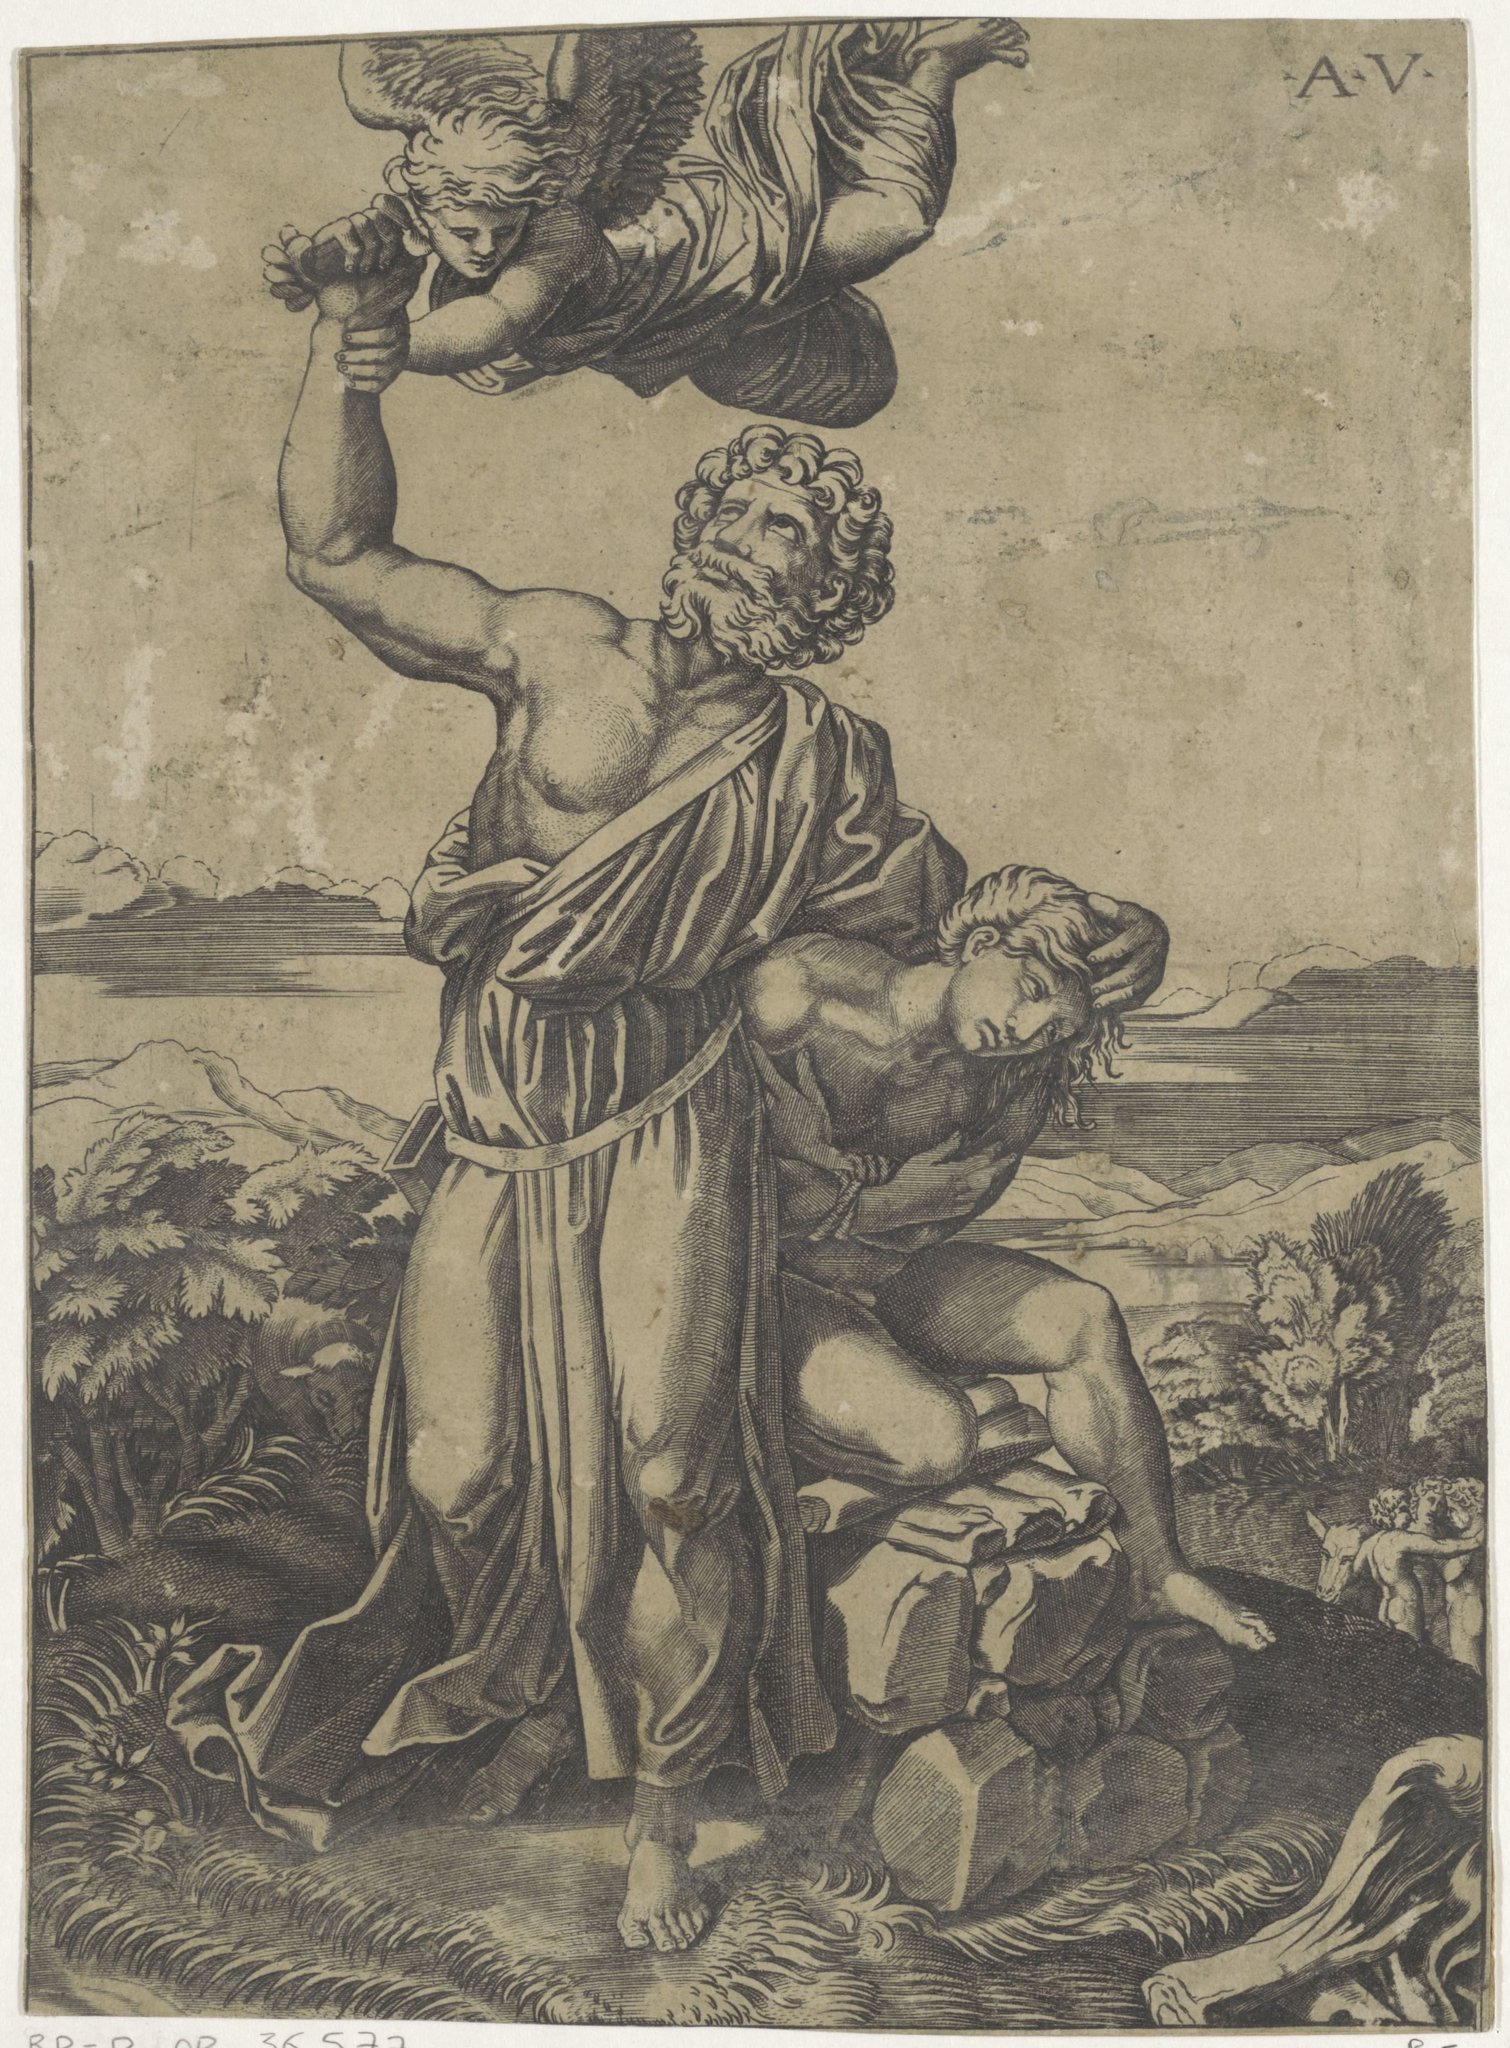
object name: print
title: Offer van Isaak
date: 1500-1536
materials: paper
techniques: engraving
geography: italy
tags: the sacrifice of isaac (genesis 22)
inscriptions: inscription: ‘L = C’, collector's mark: Lugt 240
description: Abraham staat op het punt om met zijn zwaard Isaak, die naast hem zit, te onthoofden. Een engel in de lucht grijpt het zwaard.